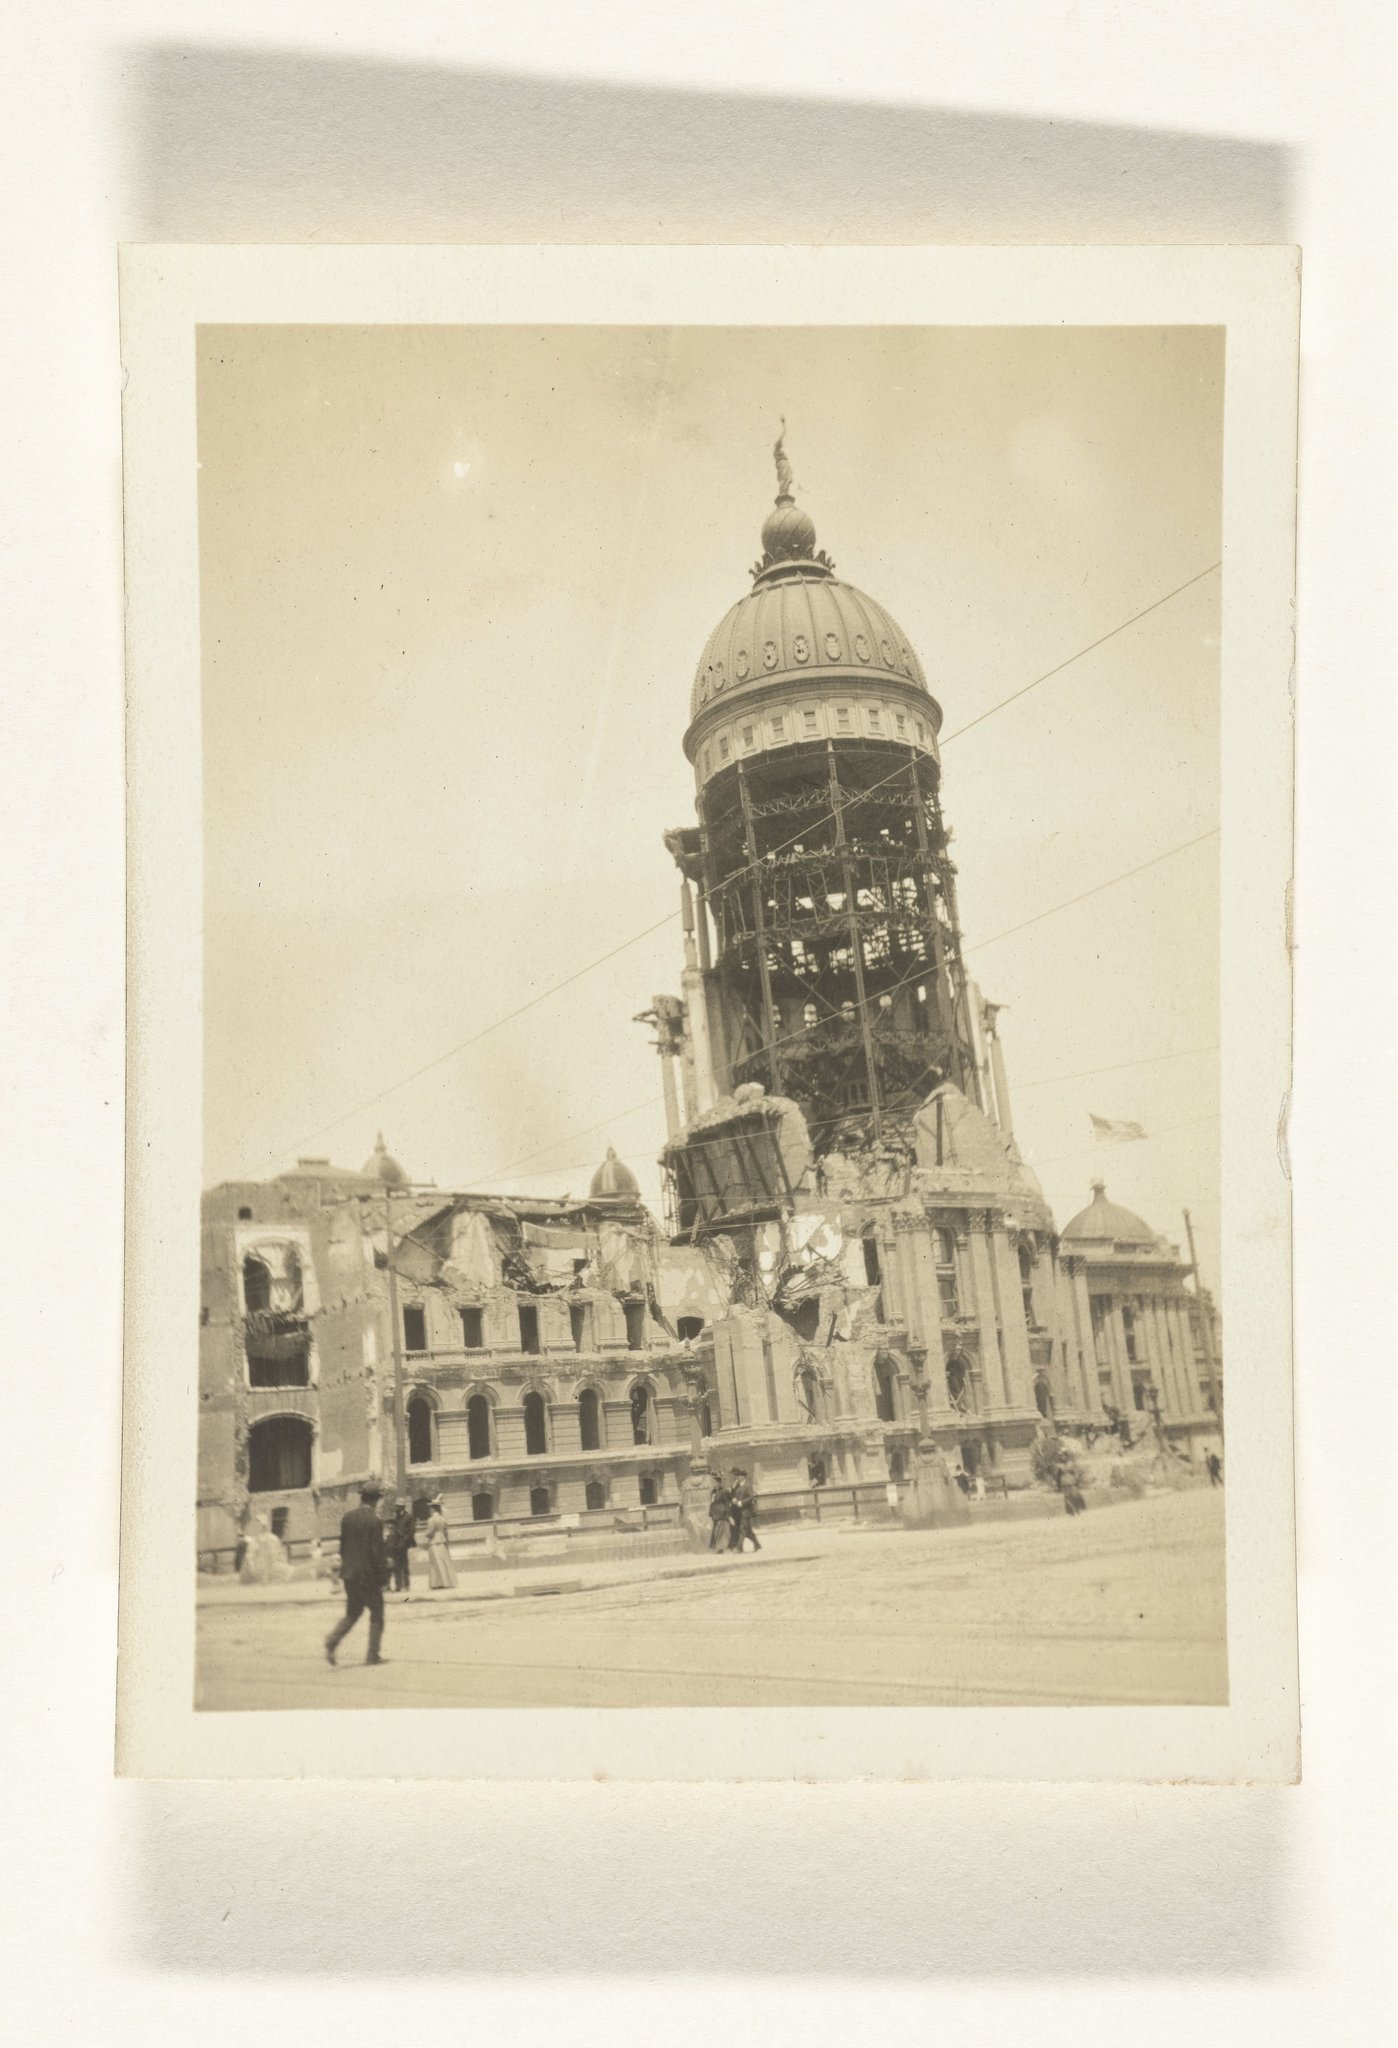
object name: photograph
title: The ruin of the City Hall at San Francisco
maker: geldolph adriaan kessler (dolph)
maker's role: fotograaf, industrieel, voetballer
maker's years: 1884-1945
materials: cardboard, photographic support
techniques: gelatin silver print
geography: san francisco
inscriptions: title: ‘The ruin of the City Hall at San Francisco’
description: Gezicht op het na de aardbeving van 1906 verwoeste stadhuis van San Francisco. Onderdeel van het fotoalbum van Dolph Kessler met opnamen die hij maakte tijdens zijn verblijf in Engeland en op een wereldreis die hij als secretaris van Henri Deterding (directeur Koninklijke Olie) ondernam naar Nederlands-Indië, Japan, China en de Verenigde Staten, tussen 1906 en 1908.